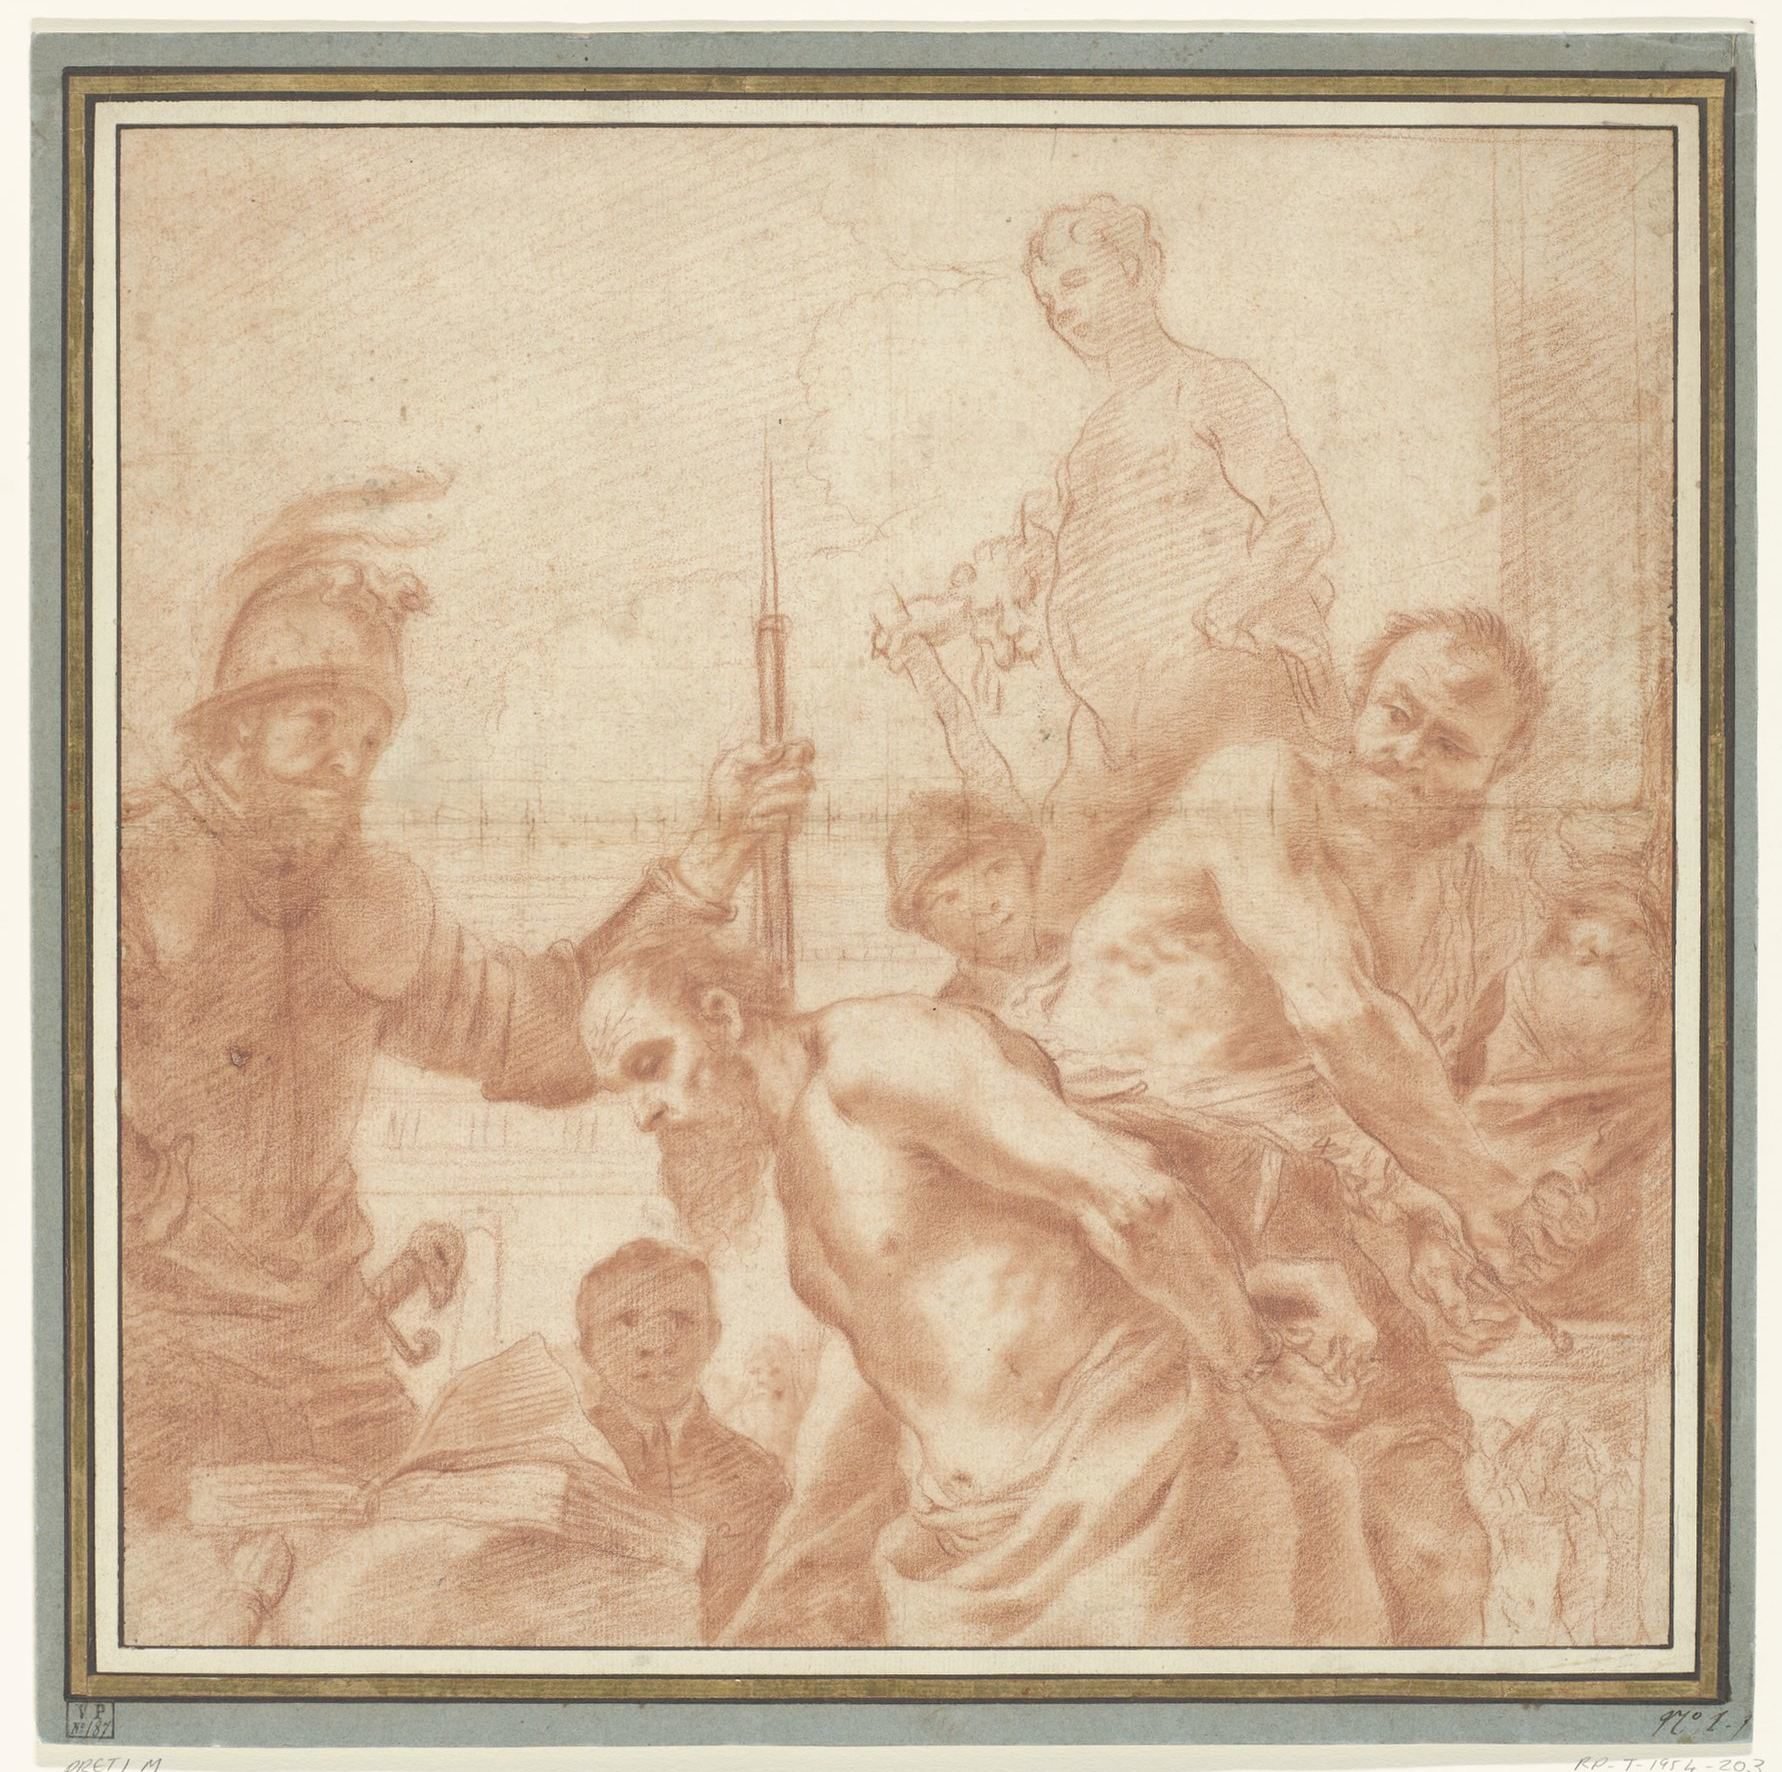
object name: drawing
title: Martelaarschap van Jakobus Major of Paulus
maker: Anonymous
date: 1623-1749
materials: chalk, paper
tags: beheading of james, the beheading of paul; maybe three fountains spring from his head